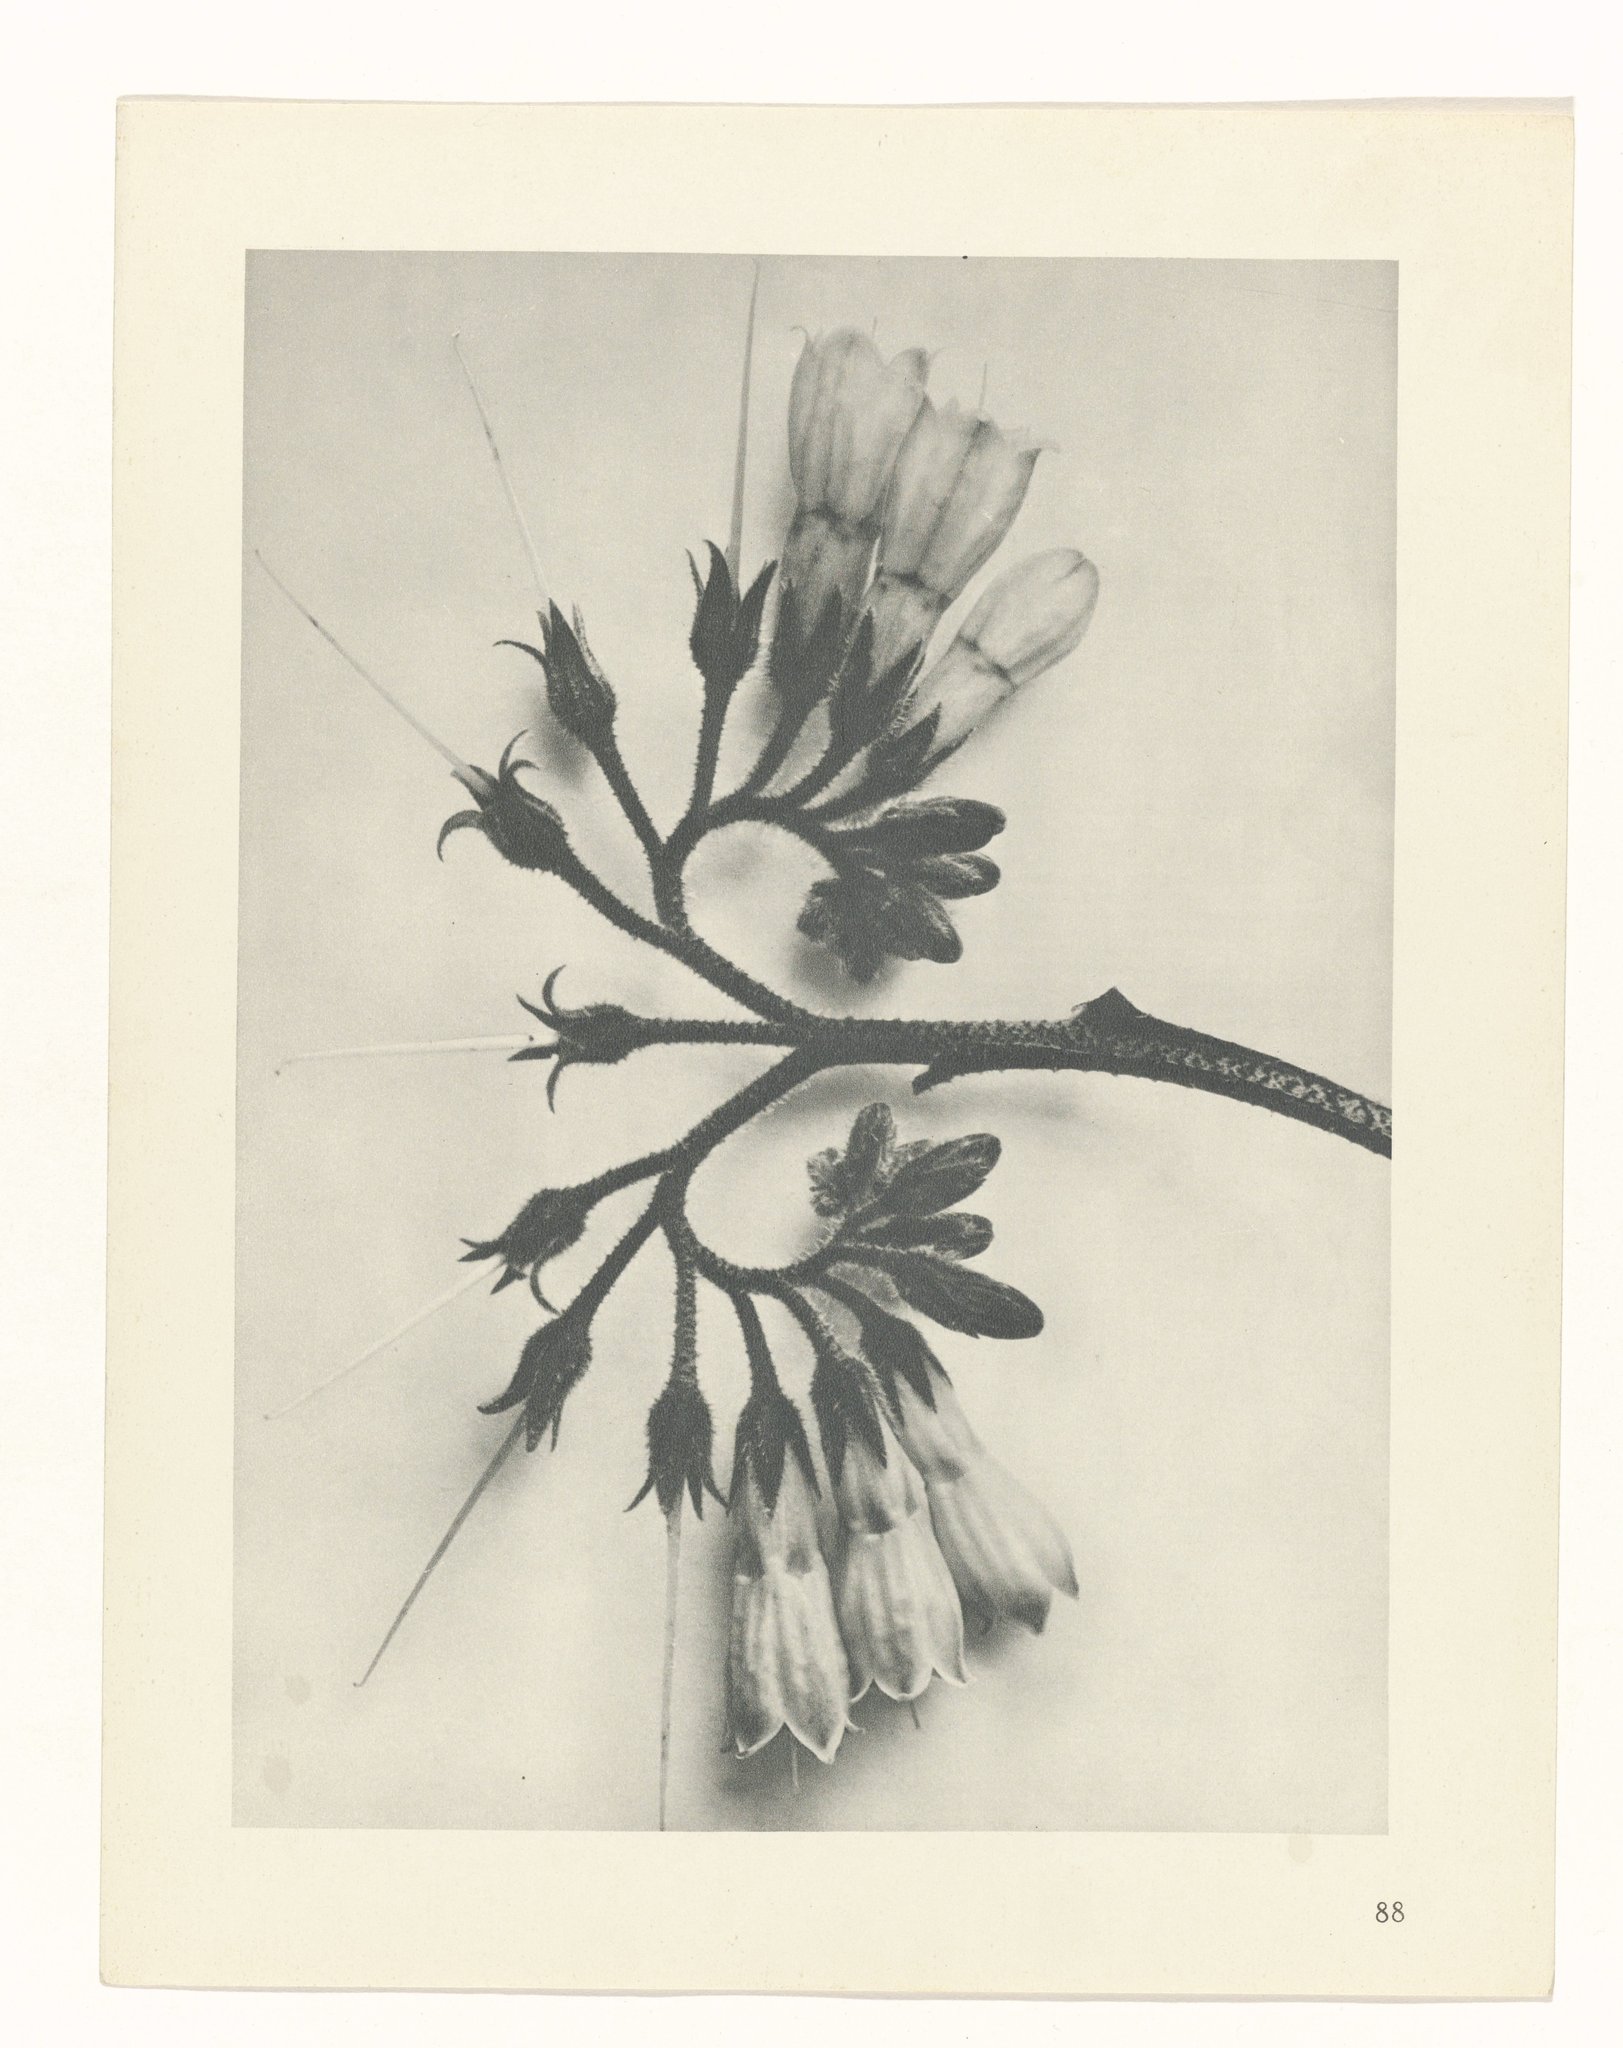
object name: photograph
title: Urformen der Kunst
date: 1928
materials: ink, paper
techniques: rotogravure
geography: berlin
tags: plants (in general)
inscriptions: number: ‘88’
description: facher Vergrößerung. Afkomstig uit losbladige uitgave.